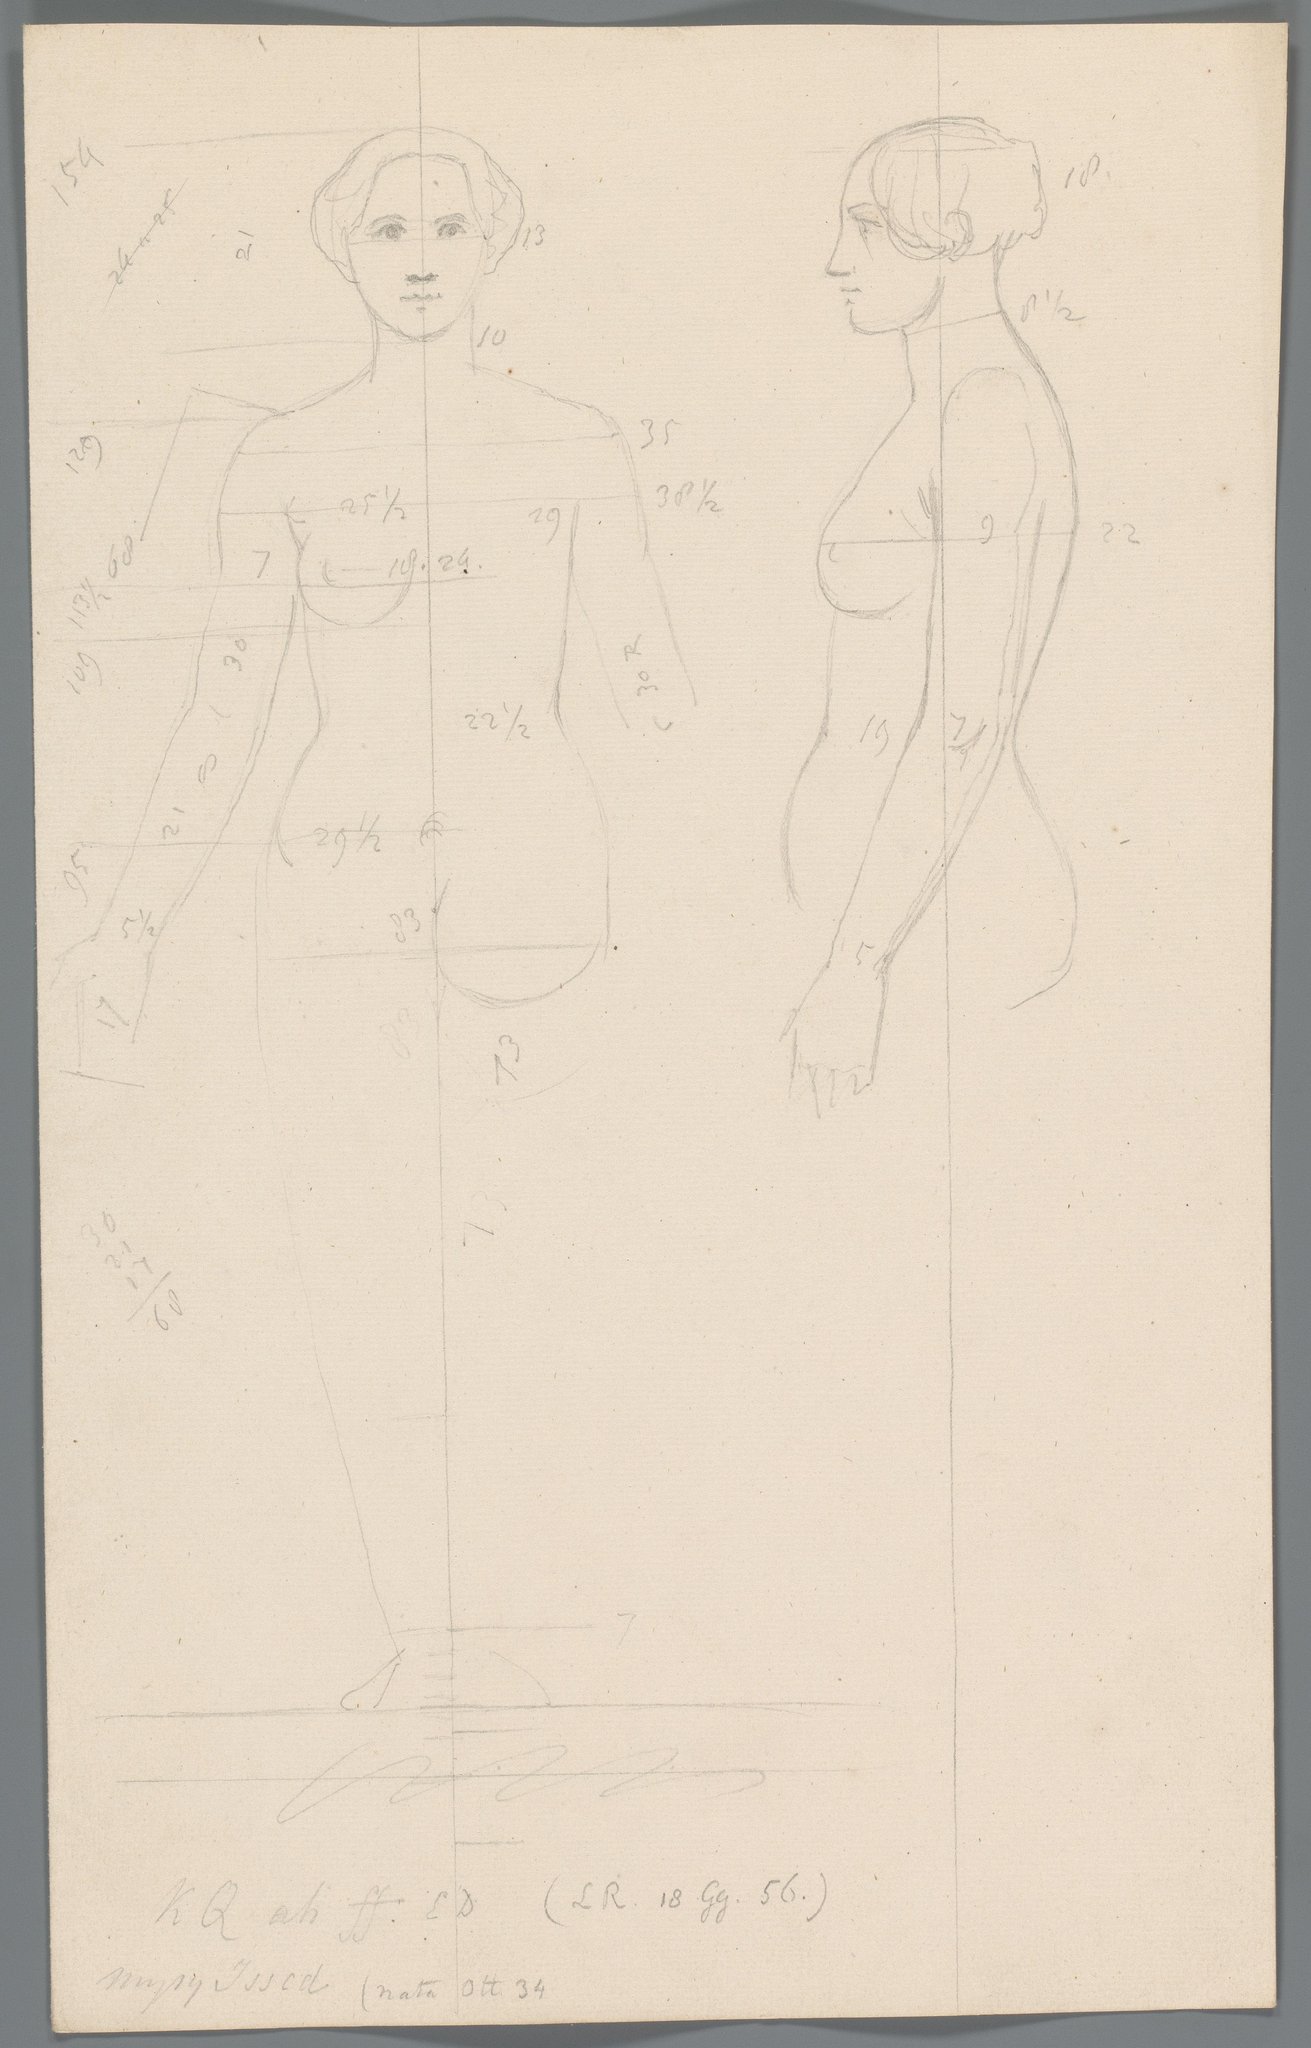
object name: drawing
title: Proportiestudie van een vrouw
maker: jacobus everhardus josephus van den berg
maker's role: draughtsman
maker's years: 1802-1861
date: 1856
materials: paper, pencil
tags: standing figure (canon, proportions) - aa - female human figure, anatomy (non-medical) - aa - female human figure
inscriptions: inscription: ‘(...) LR 18 Gg 56 (...)’